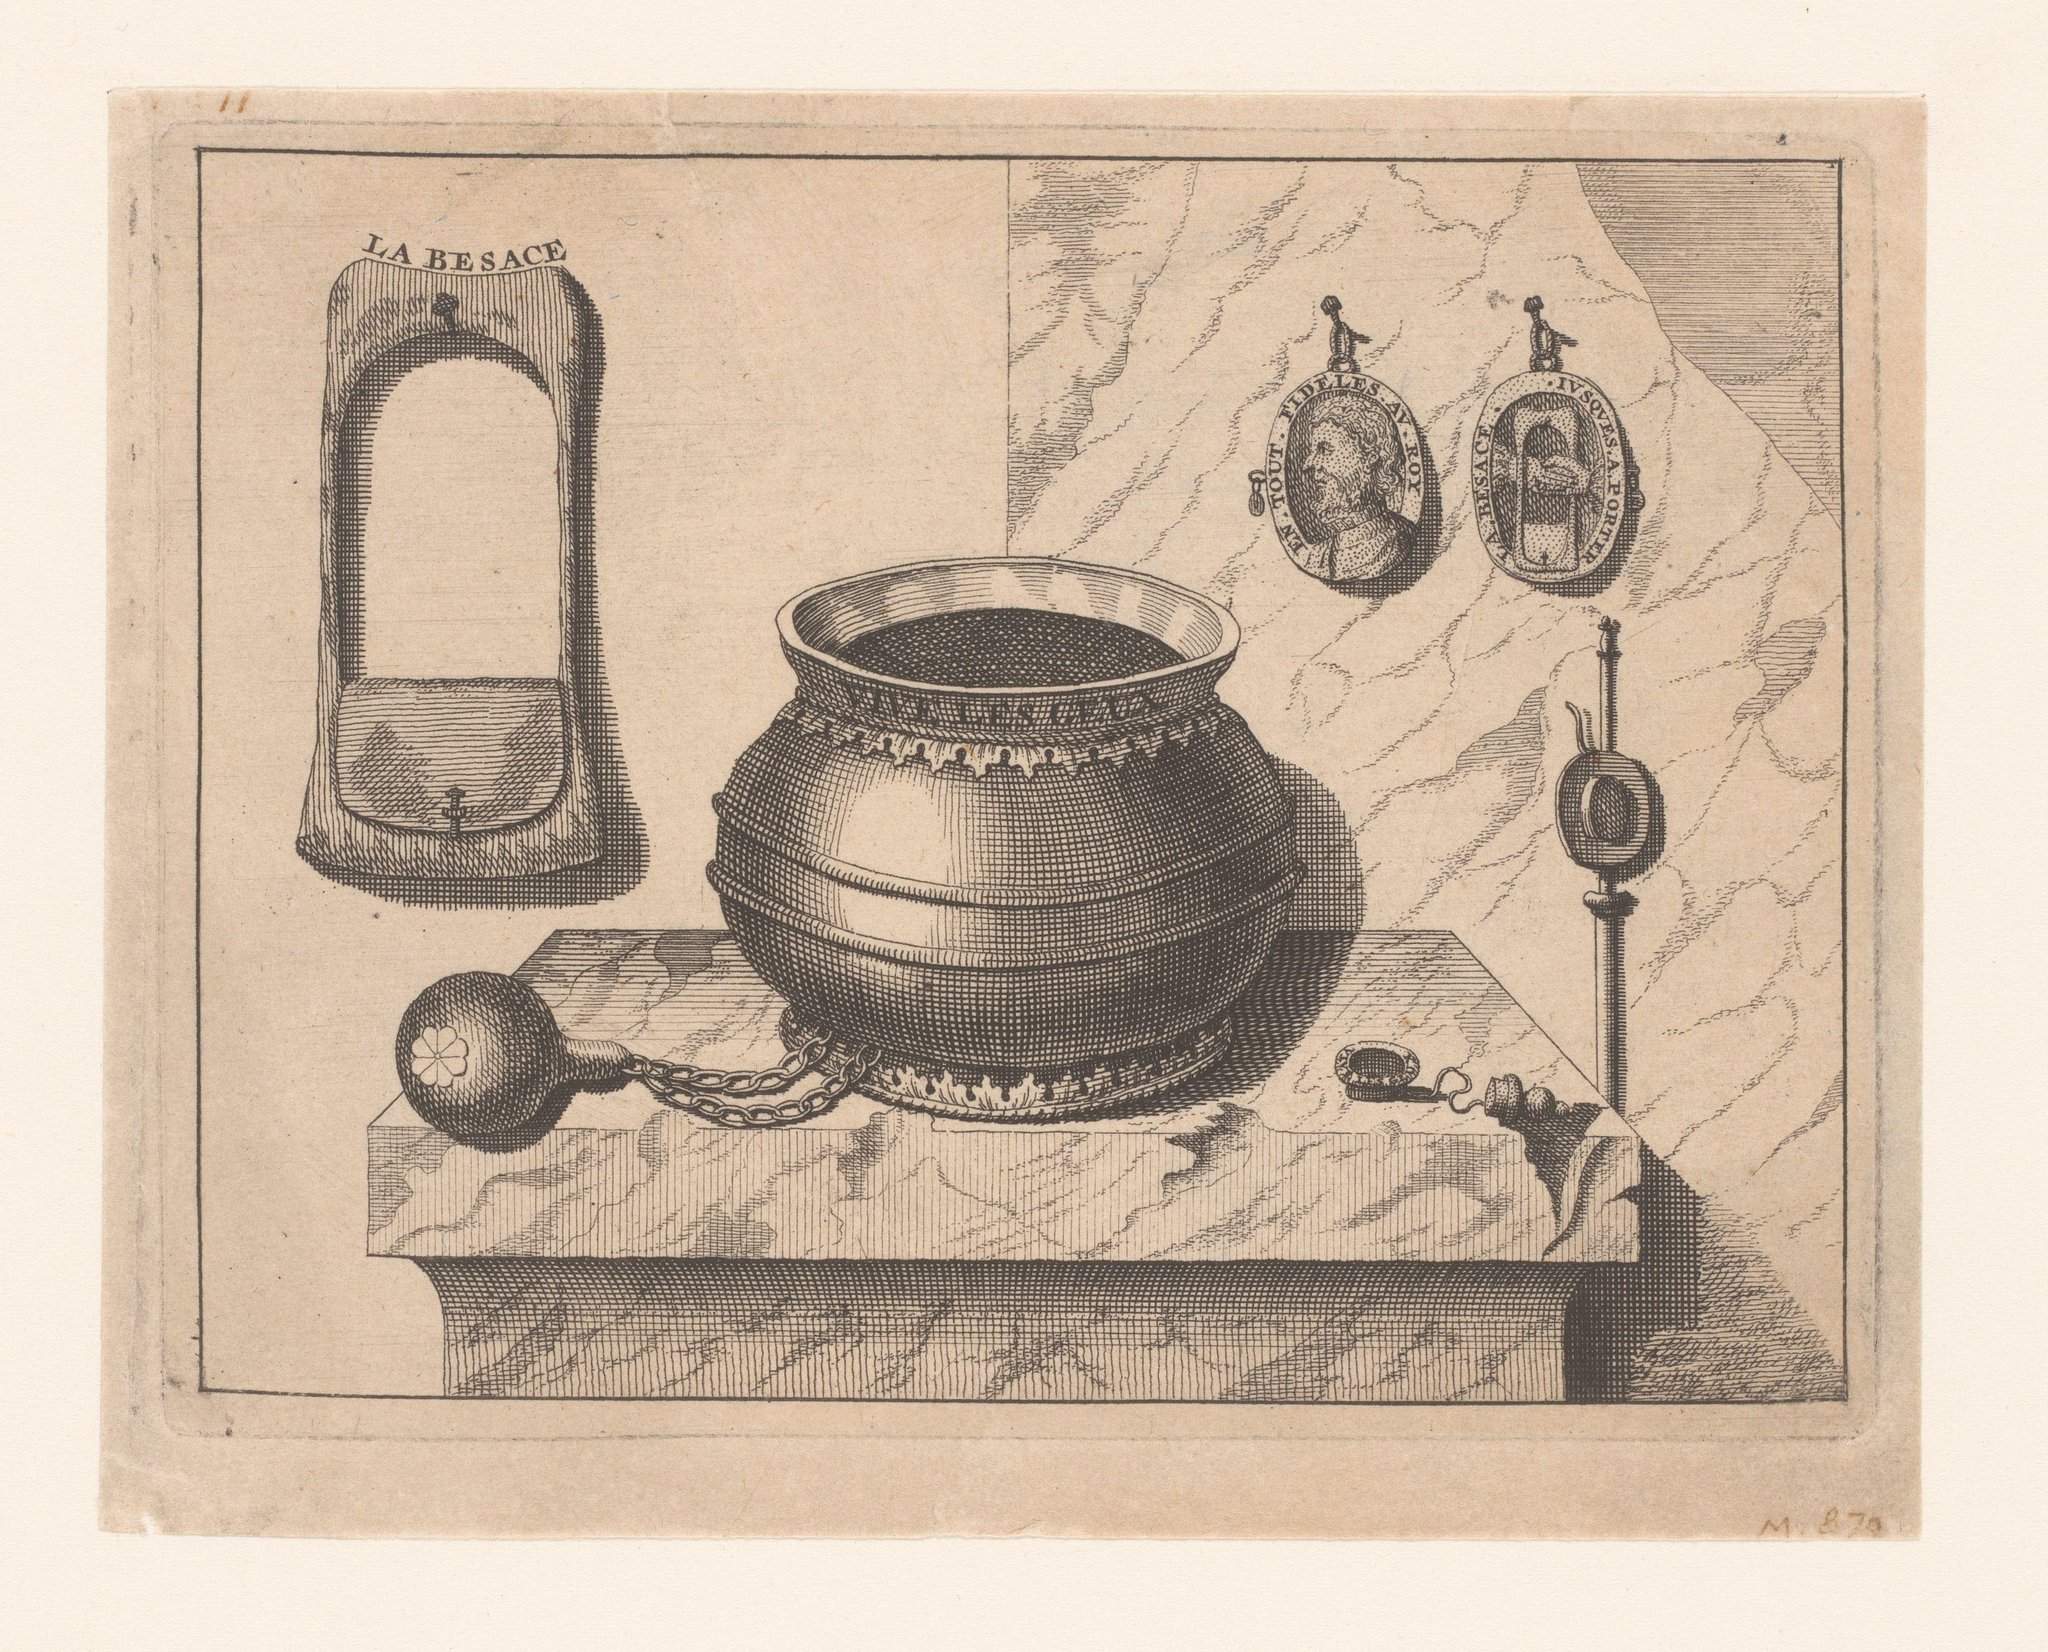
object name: print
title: Geuzennap en enkele andere attributen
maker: Anonymous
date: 1670-1690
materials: paper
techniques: etching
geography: northern netherlands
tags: pendant, trinket, 'breloque', cup, begging bowl, netherlands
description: Een dikbuikige geuzennap met zilverbeslag en het opschrift 'vive les geux', met een kleine kalebas aan een ketting, neergezet op marmeren plateau, rechts een soort sieraad met hetzelfde opschrift. Op de achtergrond links een bedelzak 'la besace' en rechts, tegen marmeren muur, twee zijden van een geuzenpenning en een staf met de vrijheidshoed of een kardinaalshoed.